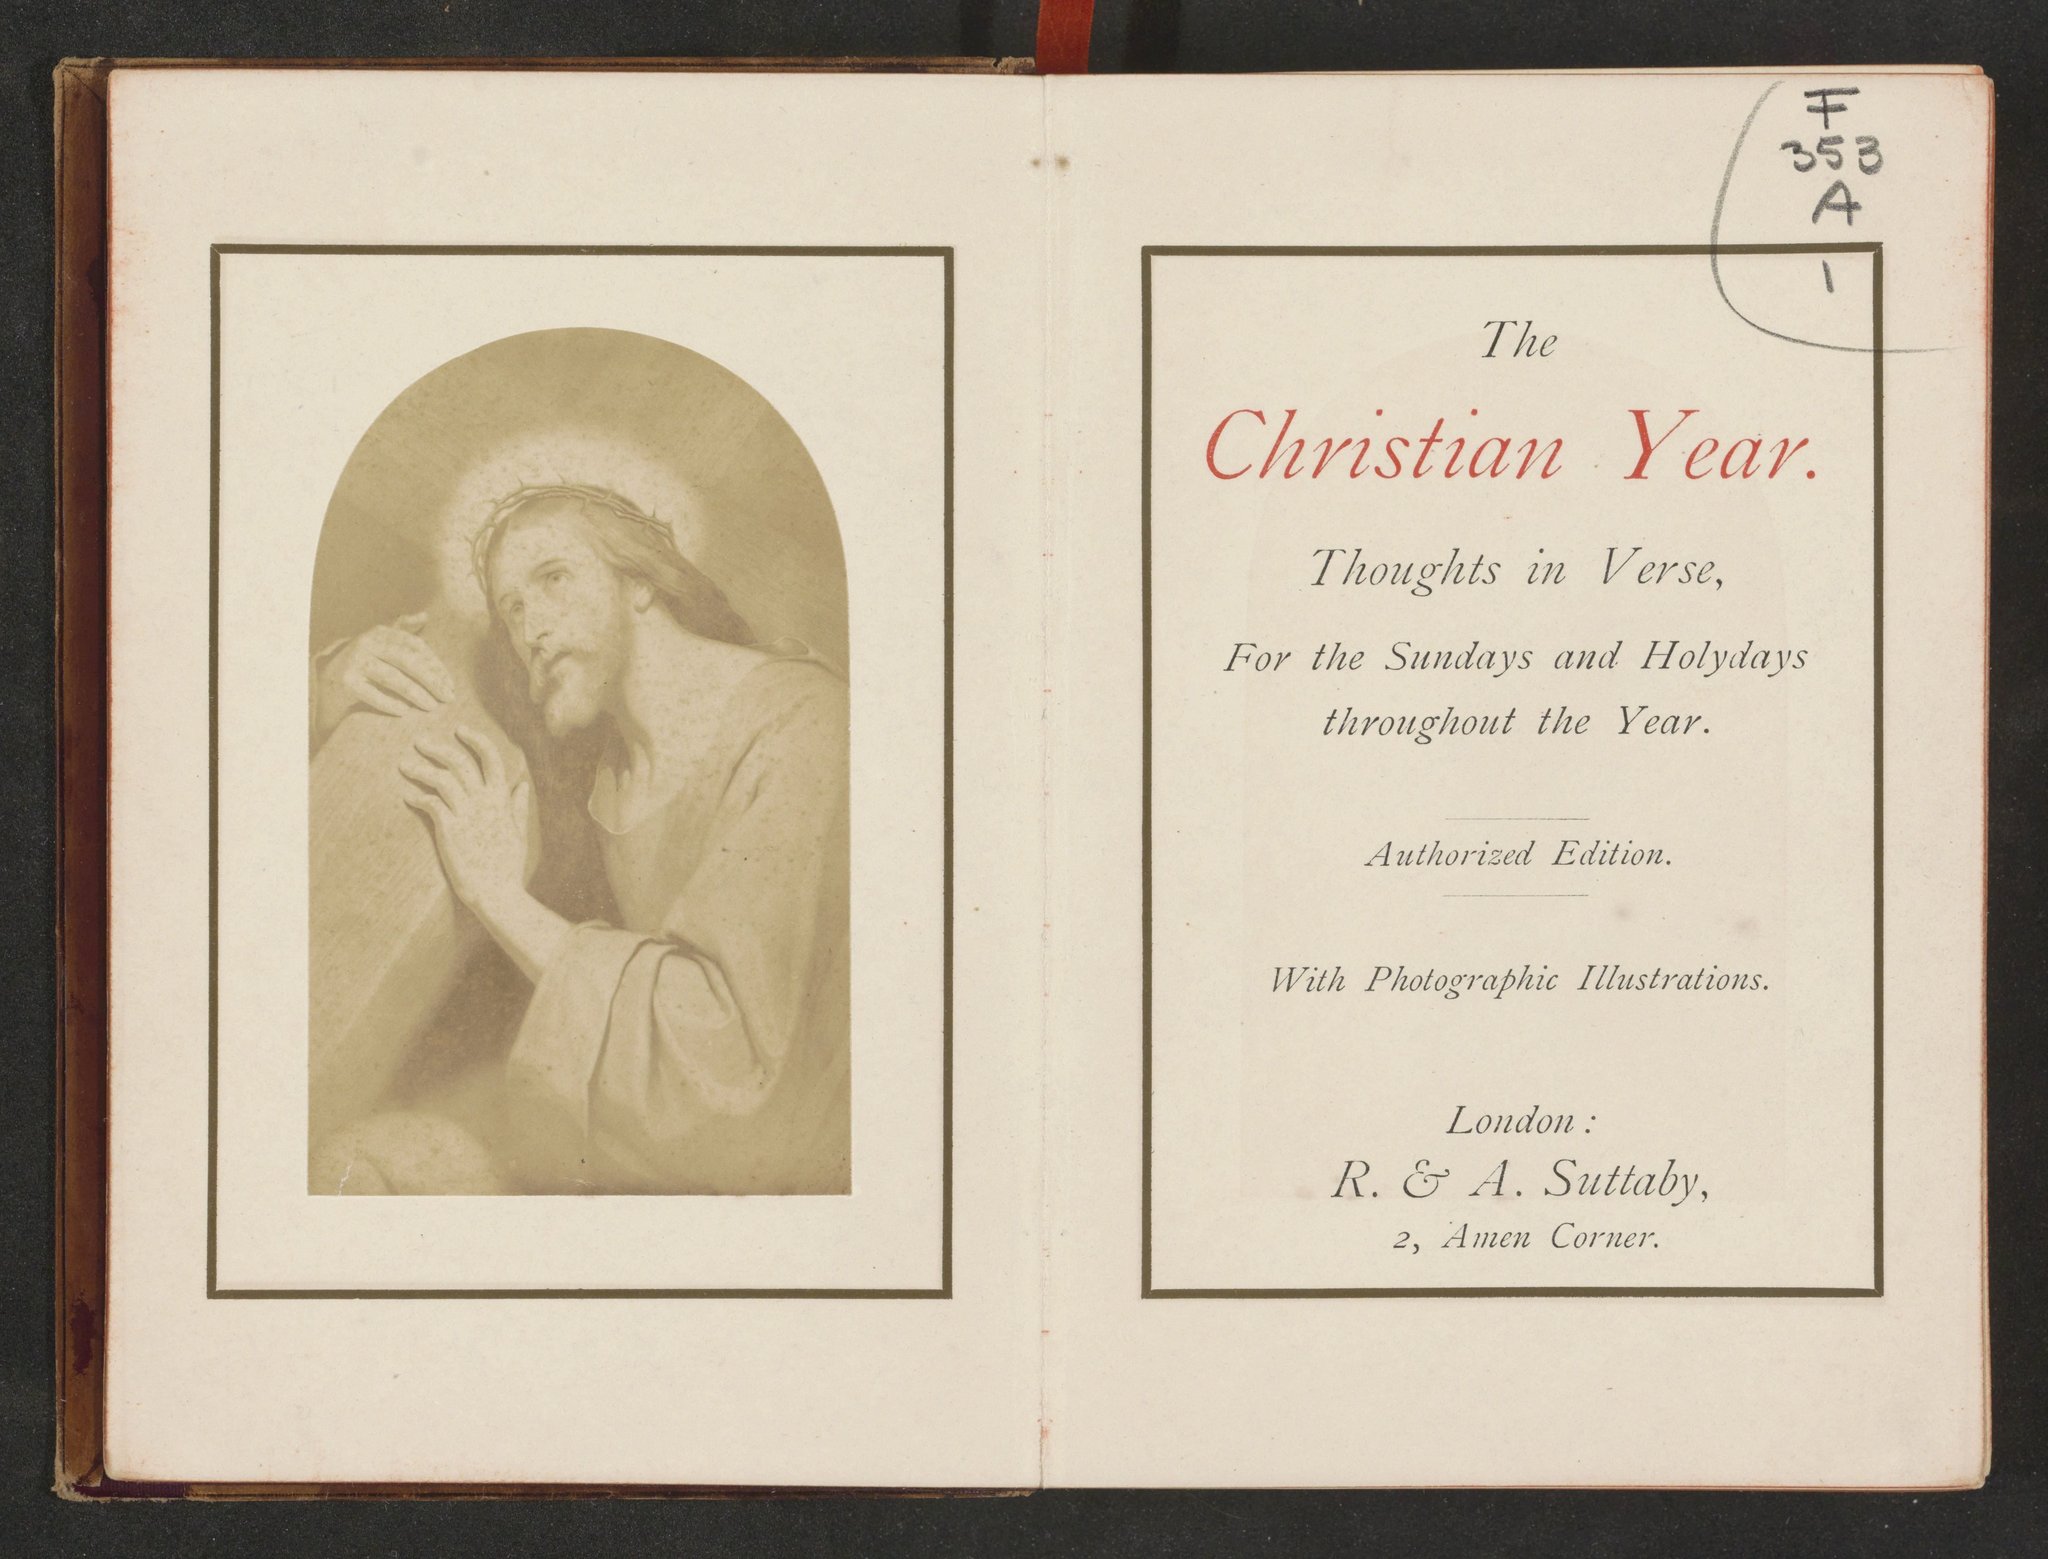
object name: reproduction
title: Fotoreproductie van een schilderij, voorstellende Christus met het kruis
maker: Anonymous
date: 1870-1875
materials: photographic support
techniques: albumen print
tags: carrying of the cross: christ bearing the cross, alone or with the help of others (e.g. simon the cyrenian)